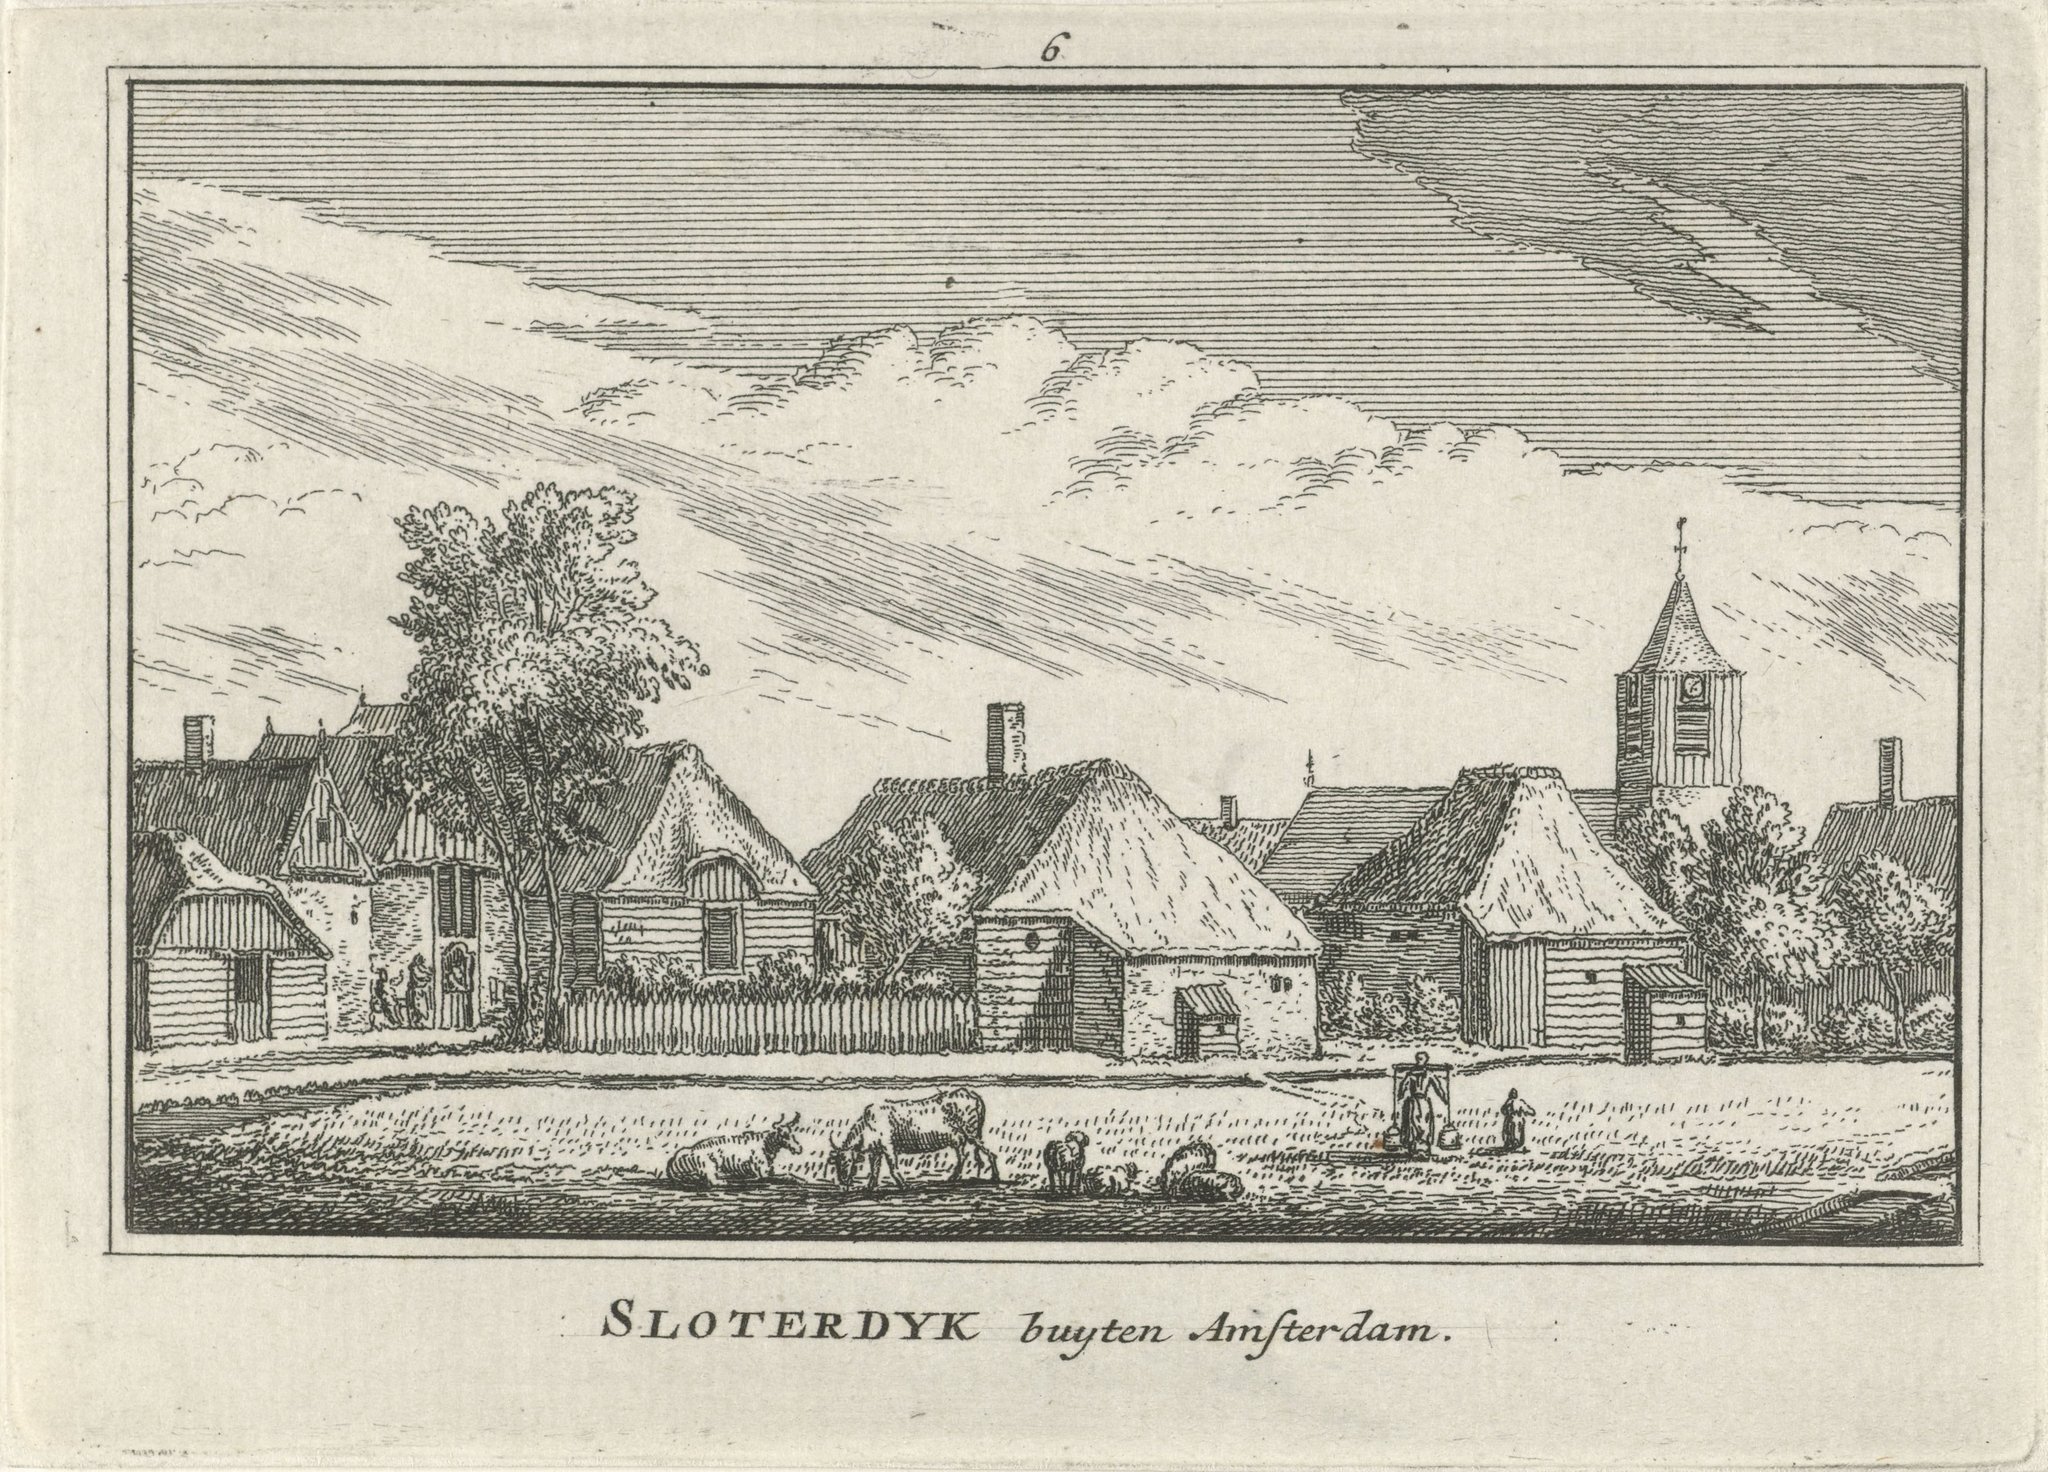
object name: print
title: Sloterdijk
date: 1727-1733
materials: paper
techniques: etching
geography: amsterdam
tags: cow, church (exterior), sheep, sloterdijk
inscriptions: collector's mark: Lugt 2228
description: Illustratie uit: Abraham Rademaker, Matthaeus Brouërius van Niedek, Isaac Le Long, Kabinet van Nederlandsche en Kleefsche outheden en (...) voorname stads- en landgebouwen, Willem Barents en Antoni Schoonenburg: Amsterdam, 1727-1733, ill. nr. 6.